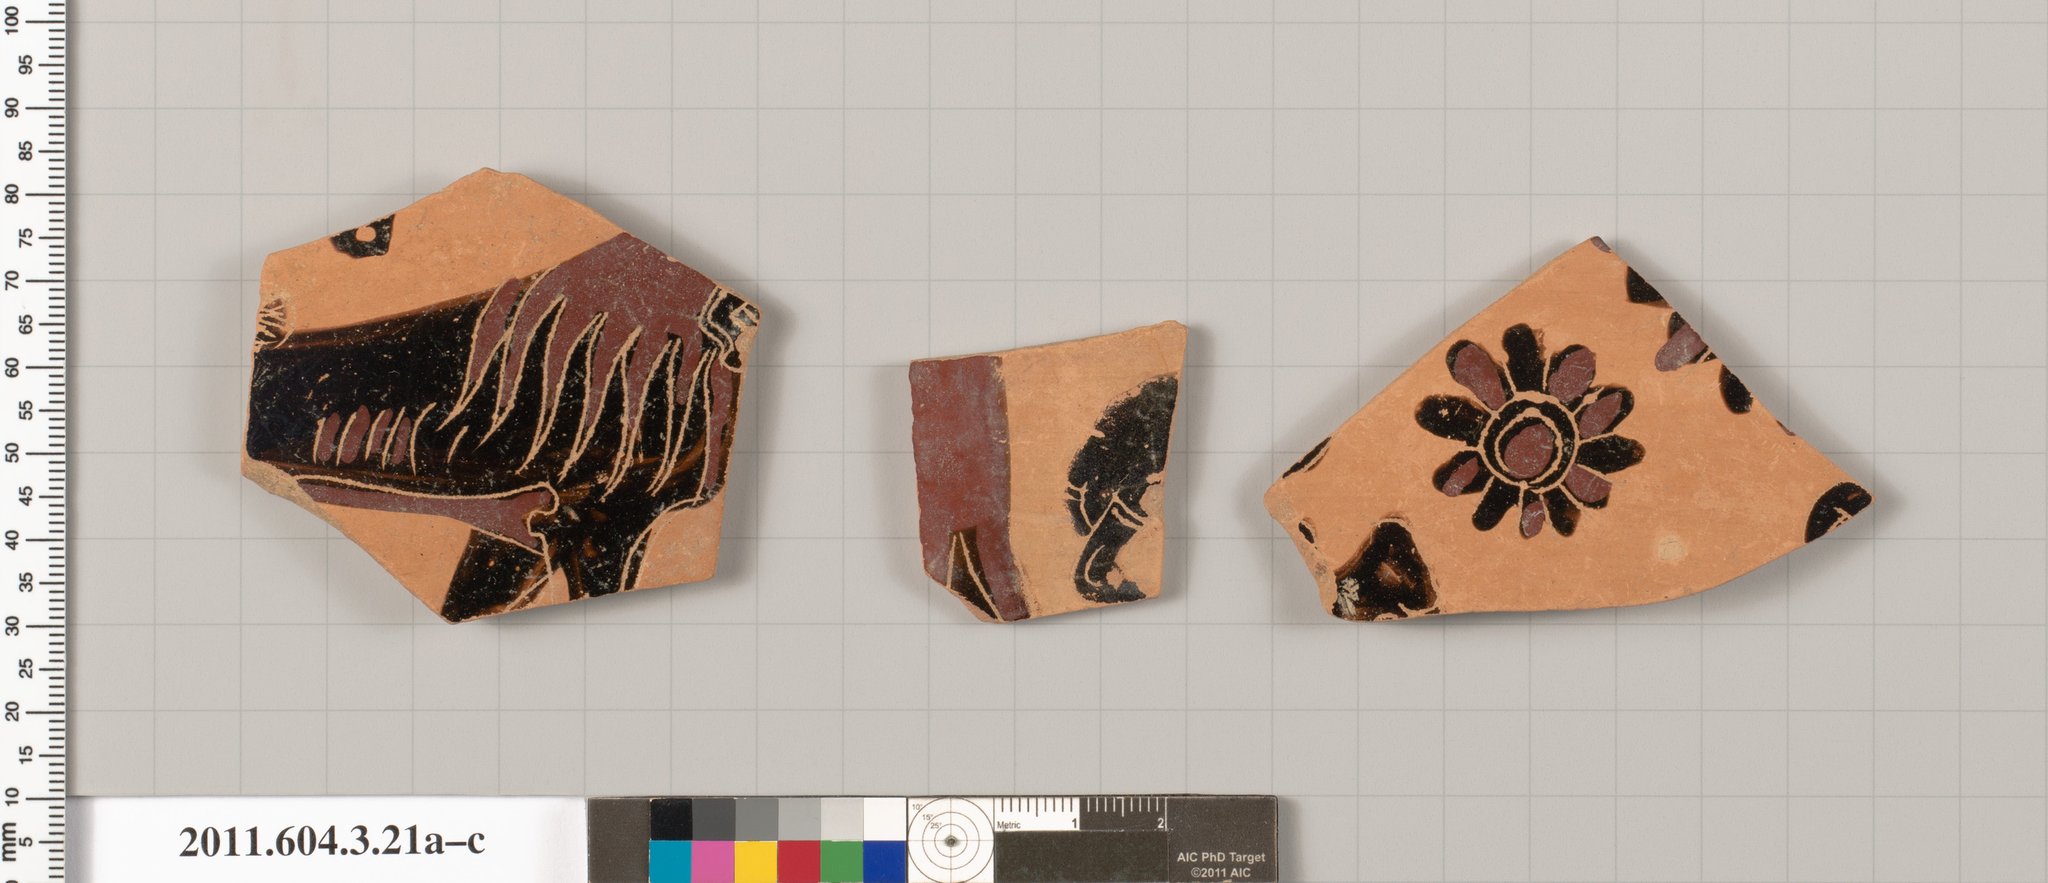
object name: oinochoe fragment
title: Terracotta fragments of an oinochoe (jug)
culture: greek, attic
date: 590-580 BCE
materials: terracotta